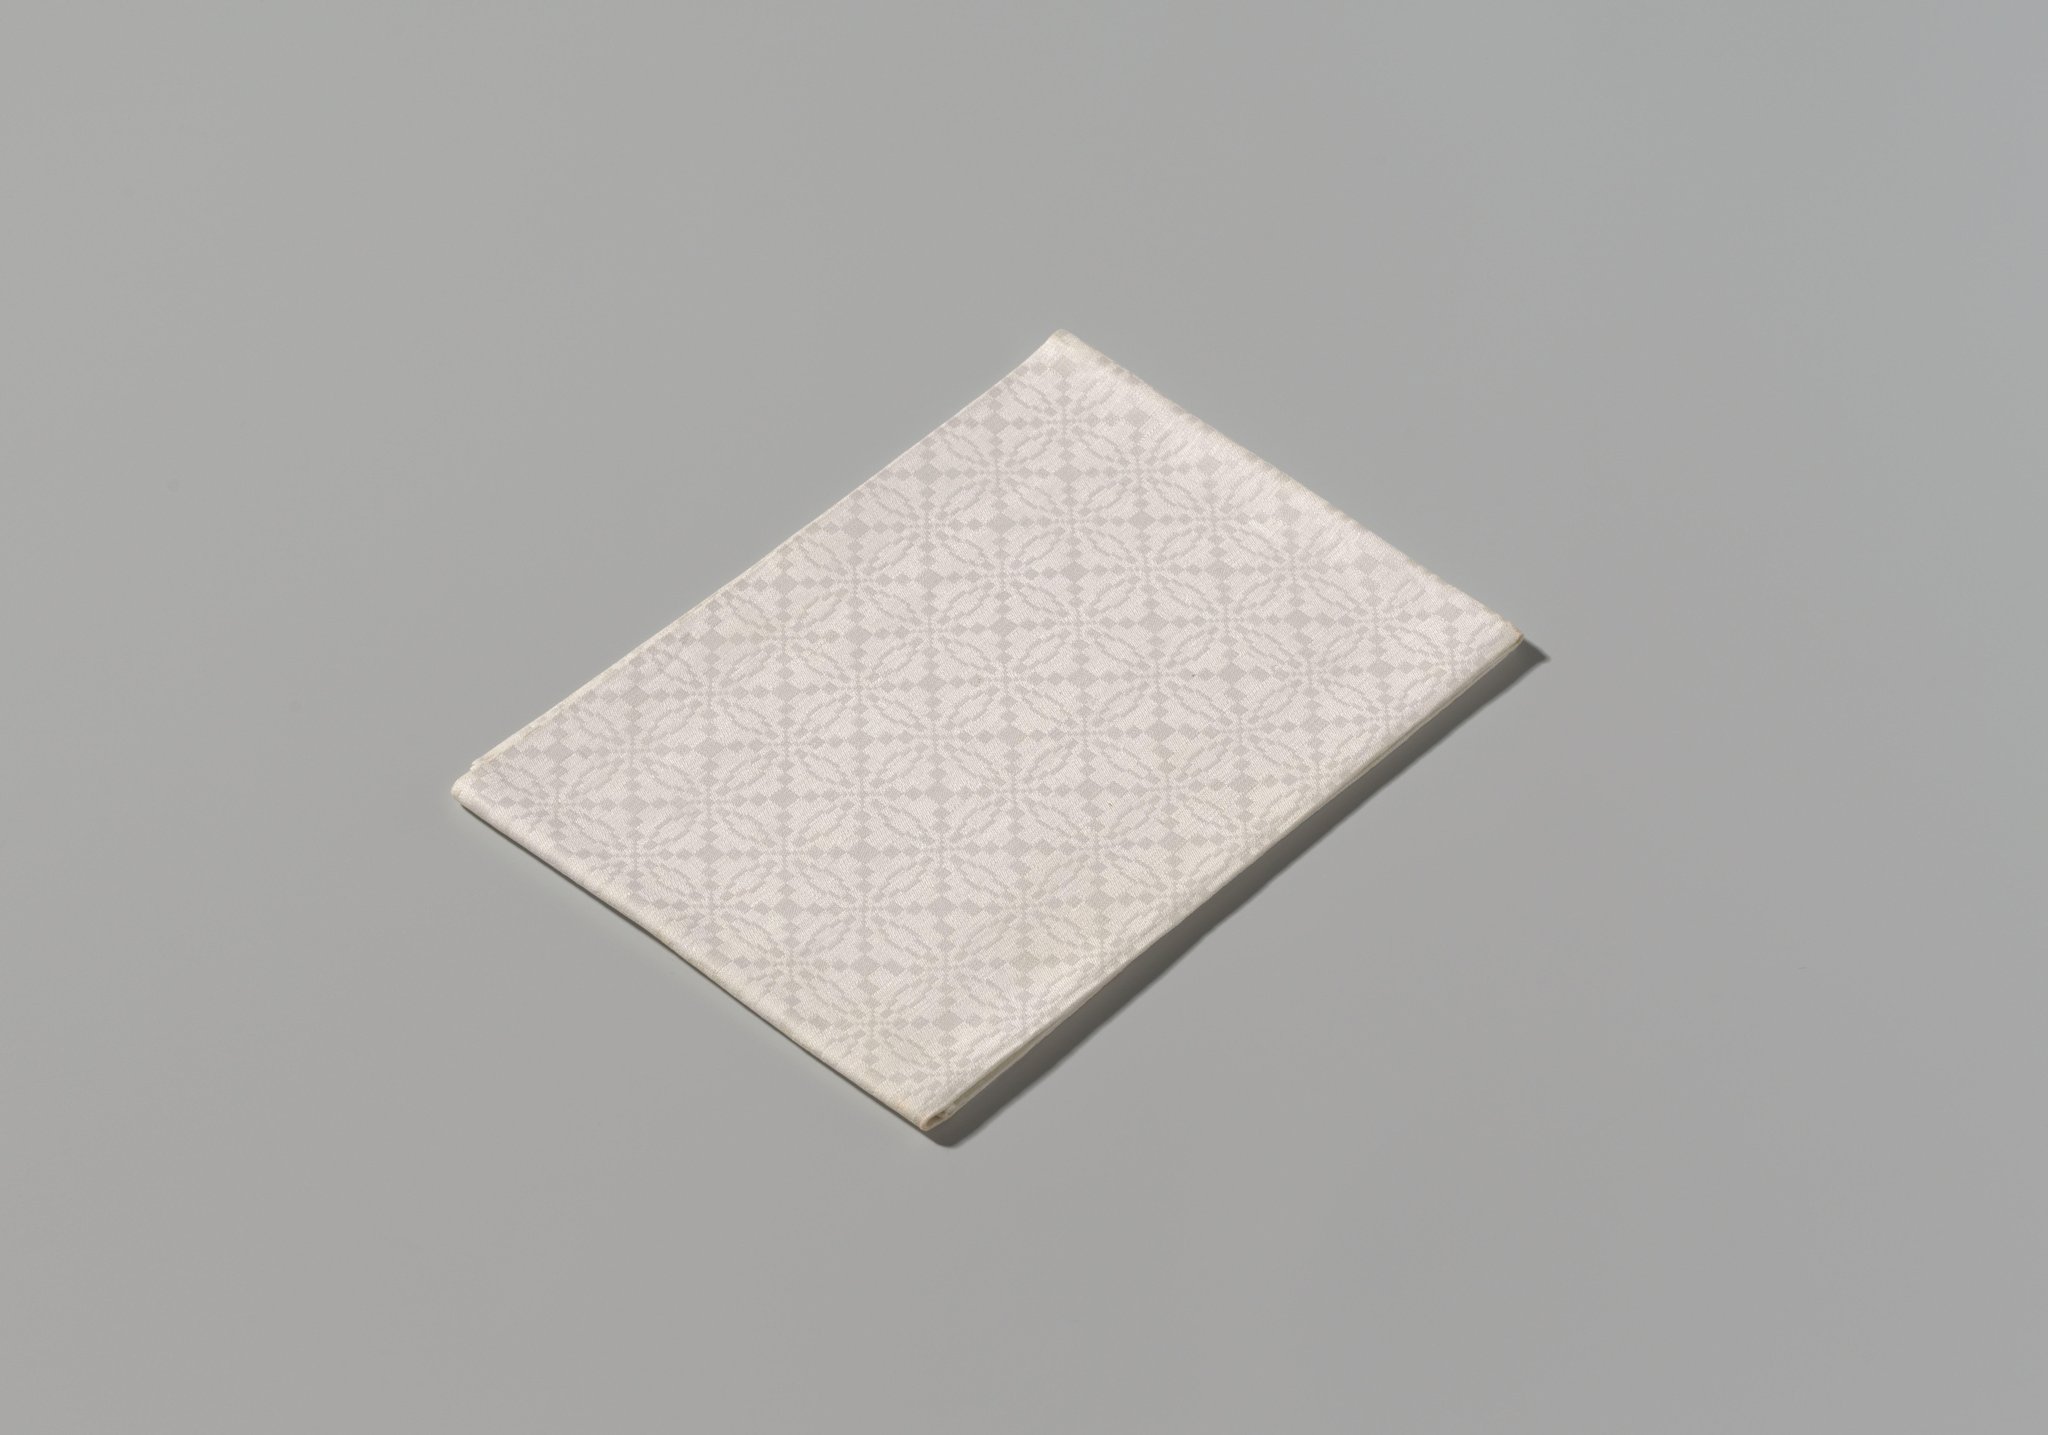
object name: napkin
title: BWit linnen pellen servet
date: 1600-1650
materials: linen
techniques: peeled fabric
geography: northern netherlands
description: Wit linnen pellen servet, gemerkt WO 70.